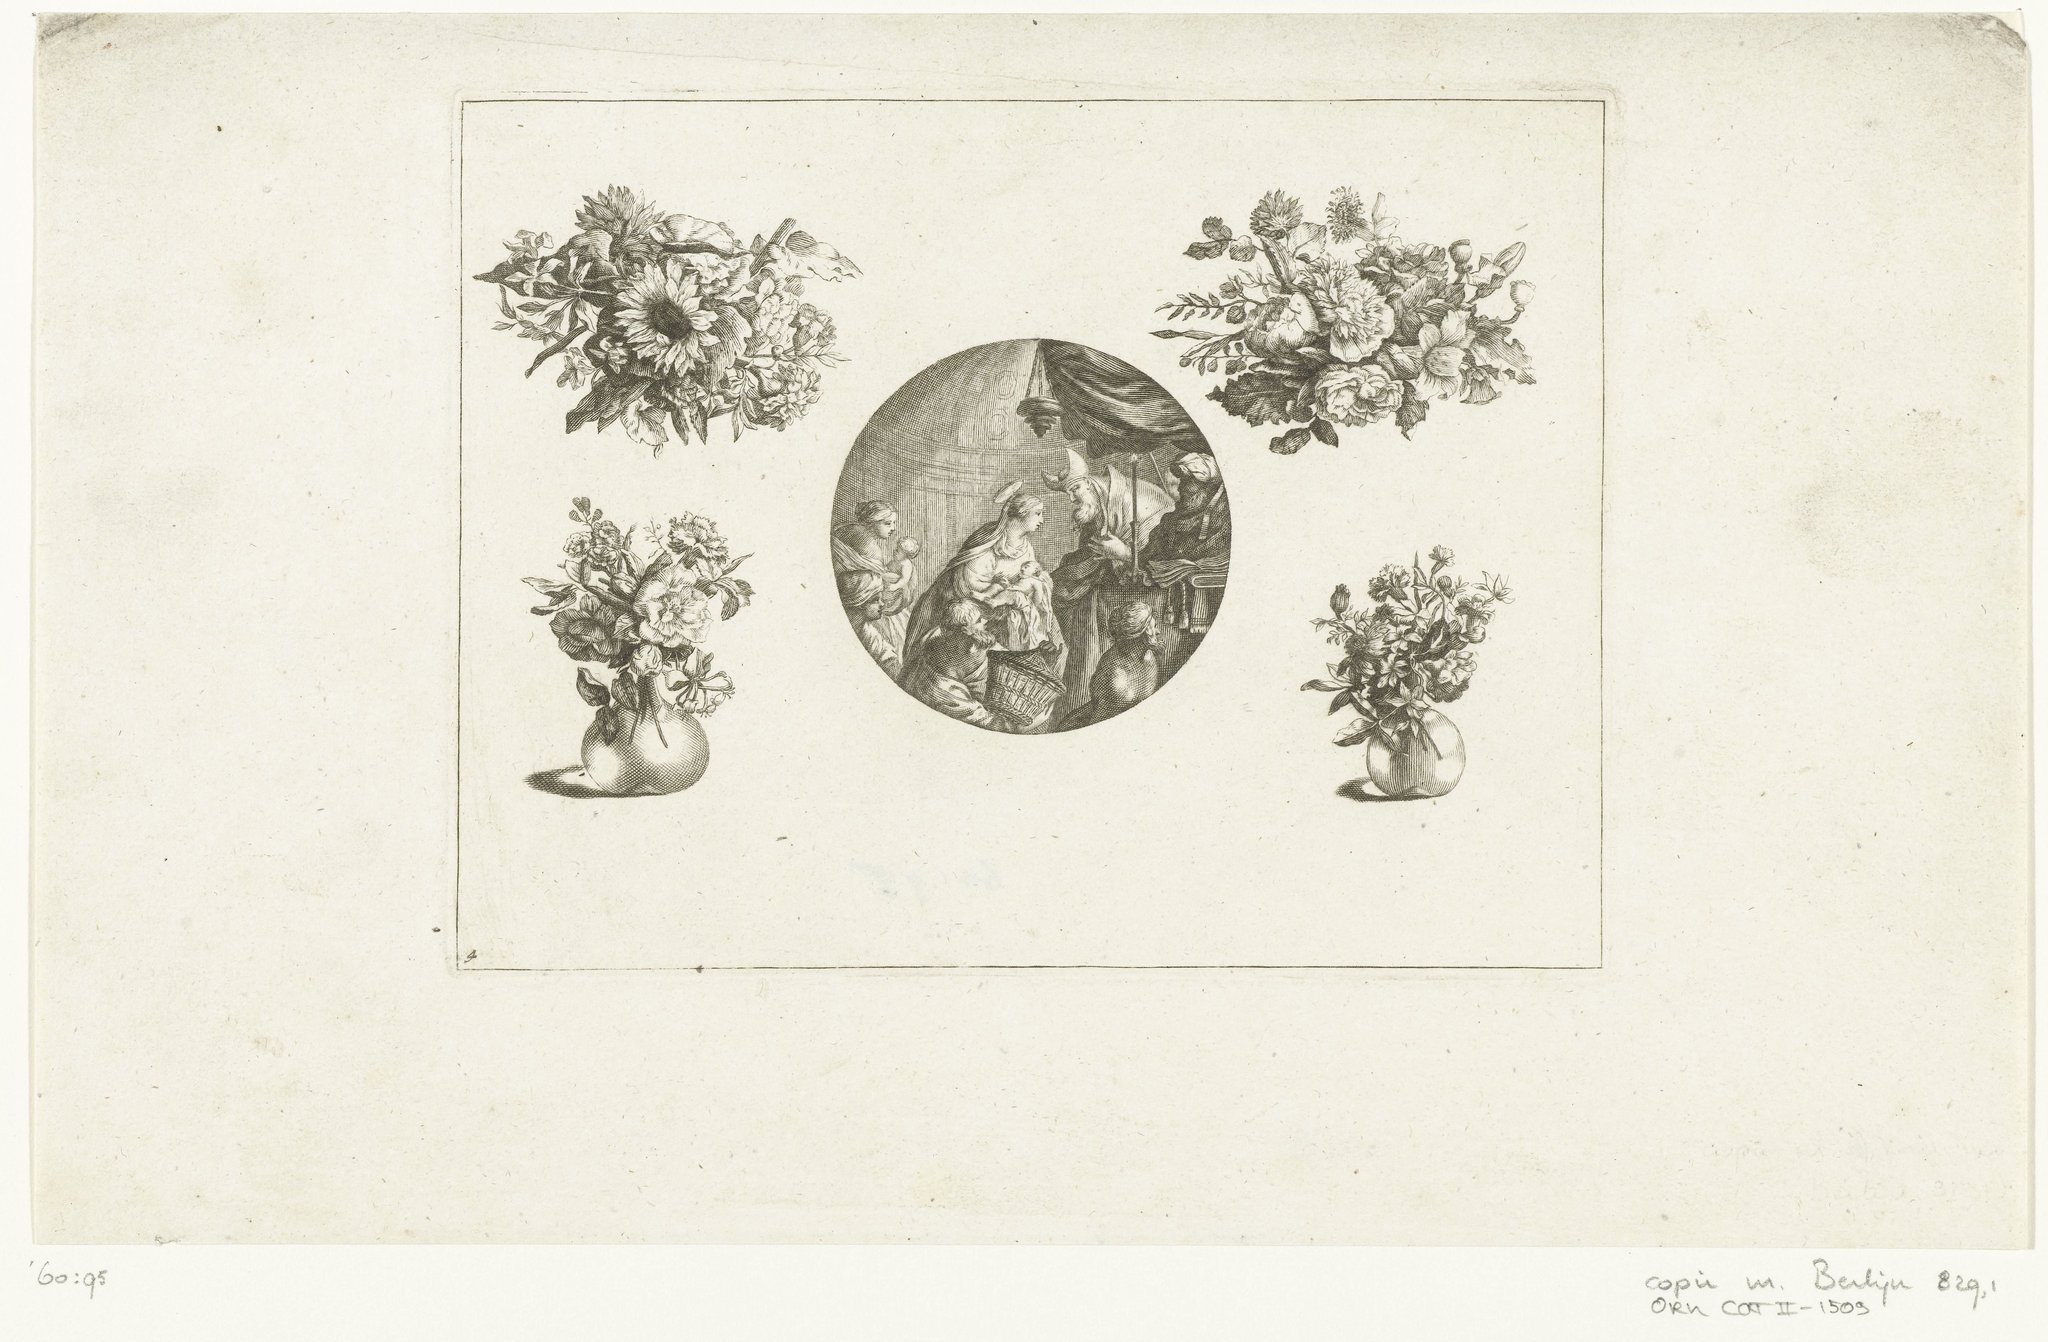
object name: print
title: Horlogekast tussen boeketten en bloemenvazen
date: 1661-1726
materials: paper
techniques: engraving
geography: amsterdam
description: Horlogekast met de Presentatie van Christus in de Tempel. Nederlandse tegenzijdige kopie naar blad uit de serie Liures De Fleurs propres pour Orfeures Et Graueurs van Jacques Vauquer. Tweede afdruk.